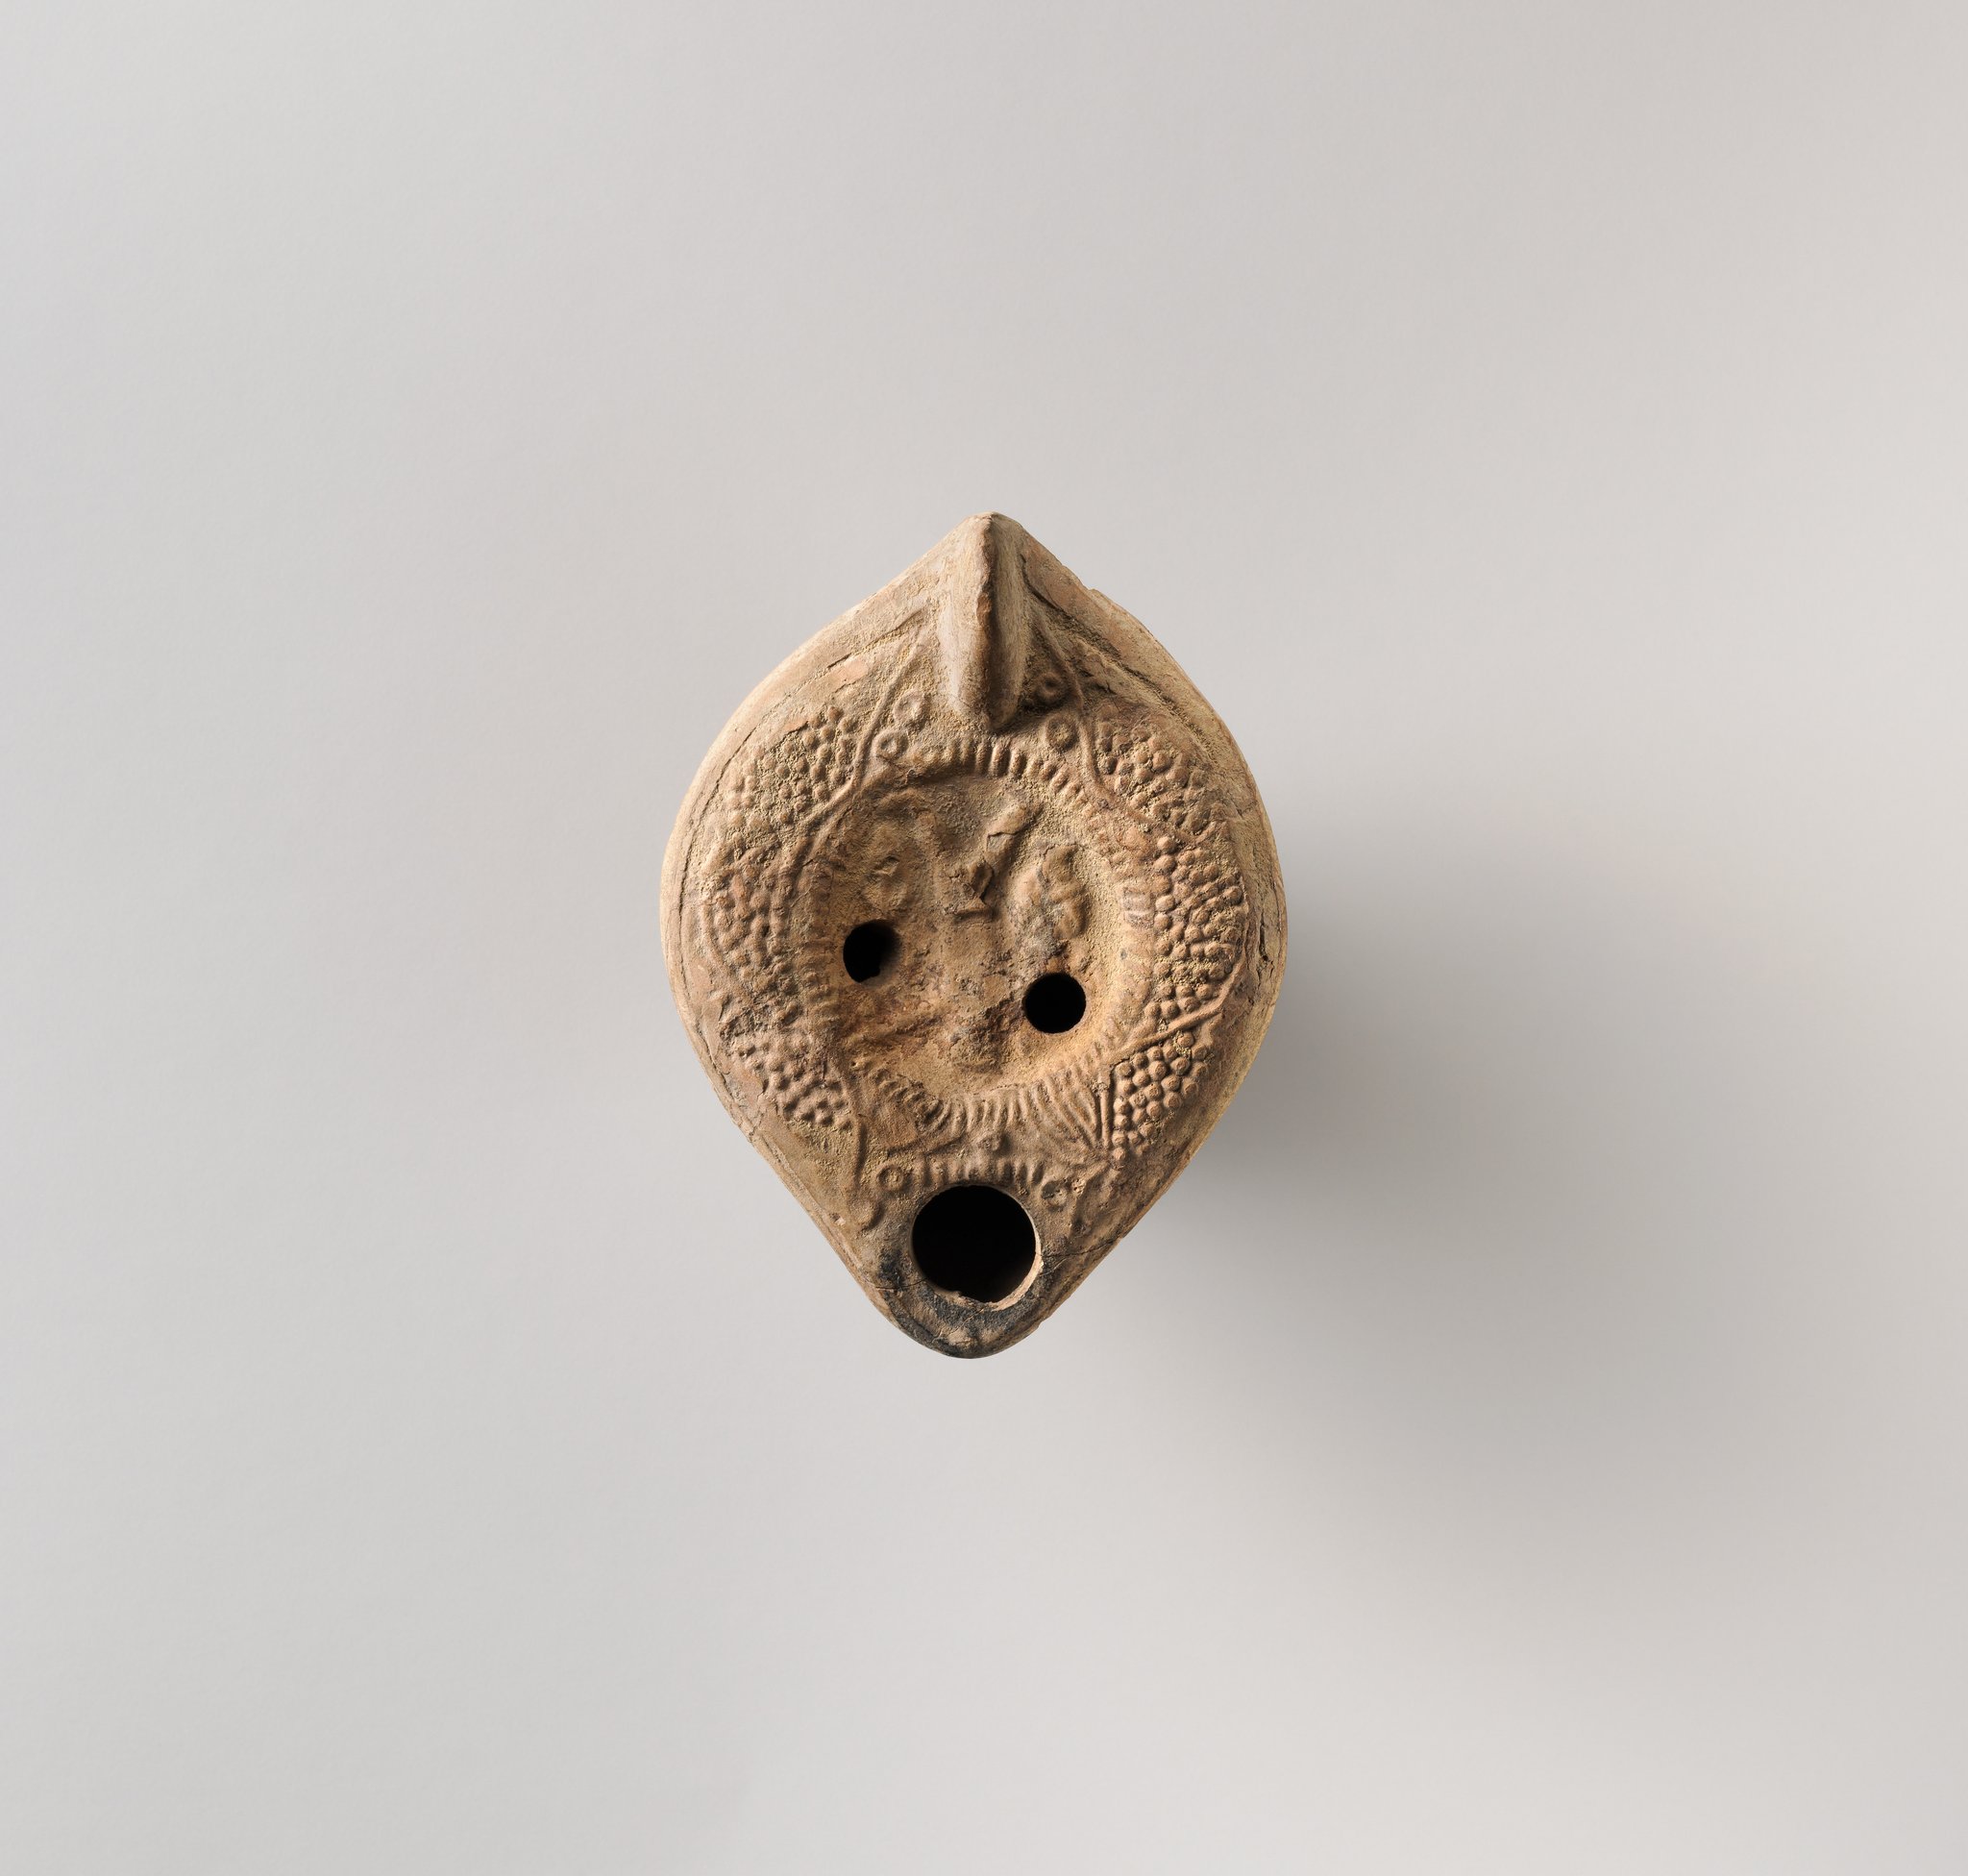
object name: lamp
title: Terracotta oil lamp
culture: roman, cypriot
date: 201-400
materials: terracotta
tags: men